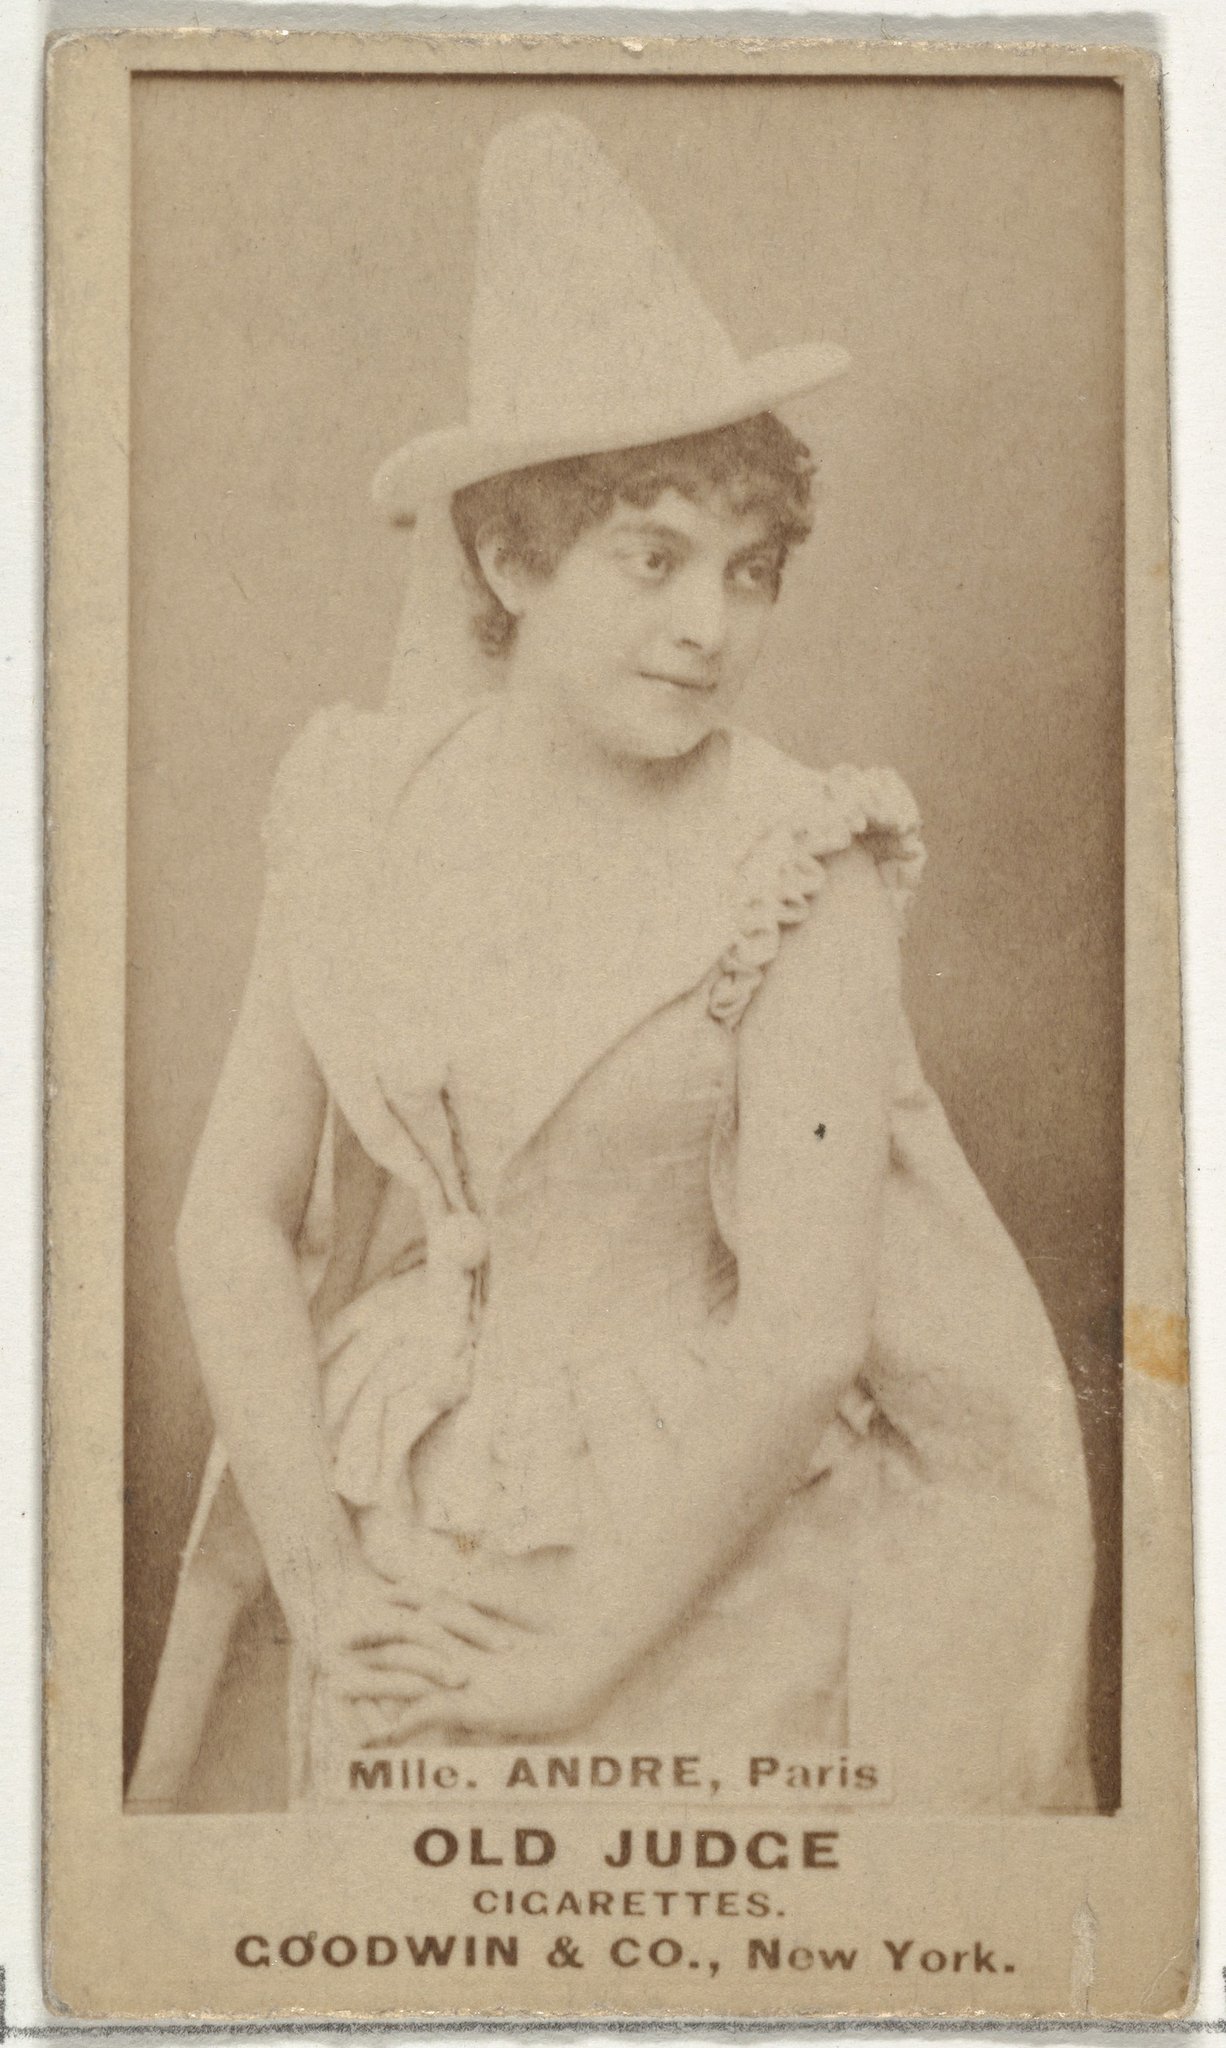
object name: photograph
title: Mlle. Andre, Paris, from the Actors and Actresses series (N171) for Old Judge Cigarettes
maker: goodwin & company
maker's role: publisher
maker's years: 1850-1950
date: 1886-1890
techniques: albumen silver print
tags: portraits,women,actresses